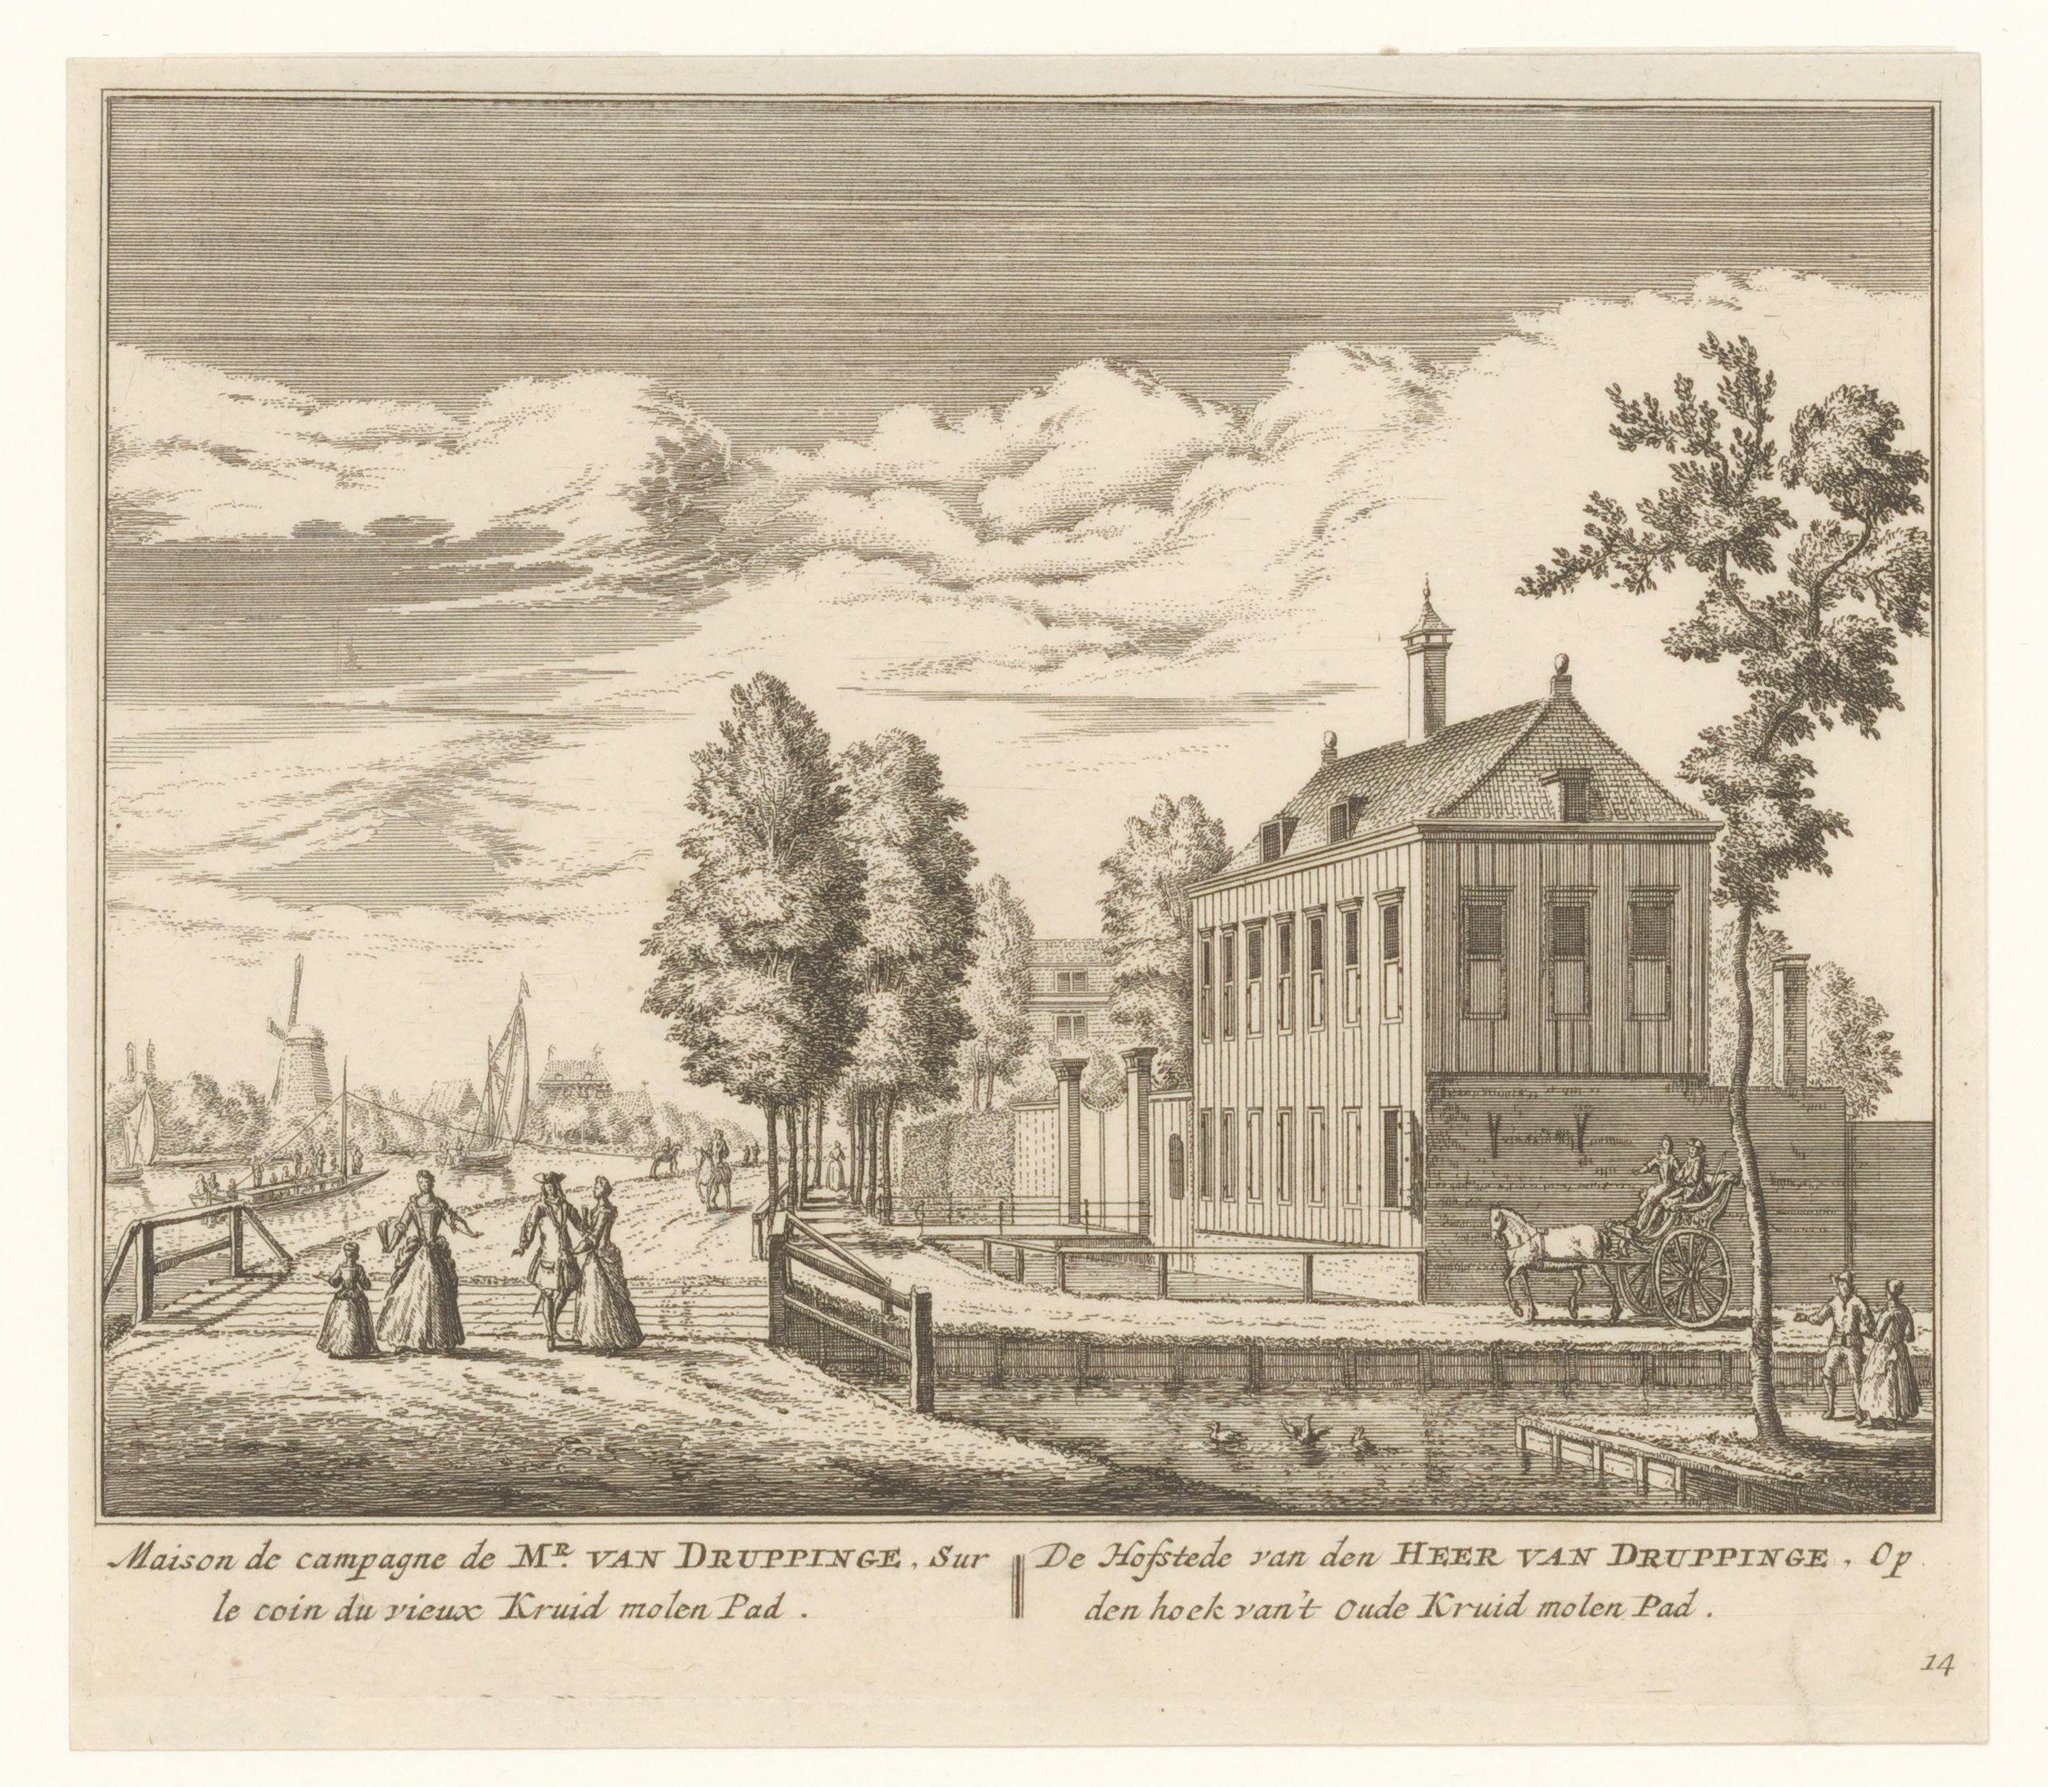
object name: print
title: De Hofstede van den Heer van Druppinge, Op den hoek van 't Oude Kruid molen Pad / Maison de campagne de Mr van Druppinge, Sur le coin du vieux Kruid molen Pad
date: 1730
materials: paper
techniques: etching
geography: amsterdam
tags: sailing-ship, sailing-boat, city-view in general; 'veduta', river, rural housing, e.g. country-house, villa, cottage, windmill in landscape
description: Prent waarschijnlijk uit: Tijsens, Gijsbert. Hollands Arcadia, of de vermaarde rivier den Amstel (...) naar 't léven getekend en in 't ligt gebragt door Abraham Rademaker (...). Amsterdam: Leonardus Schenk, 1730.